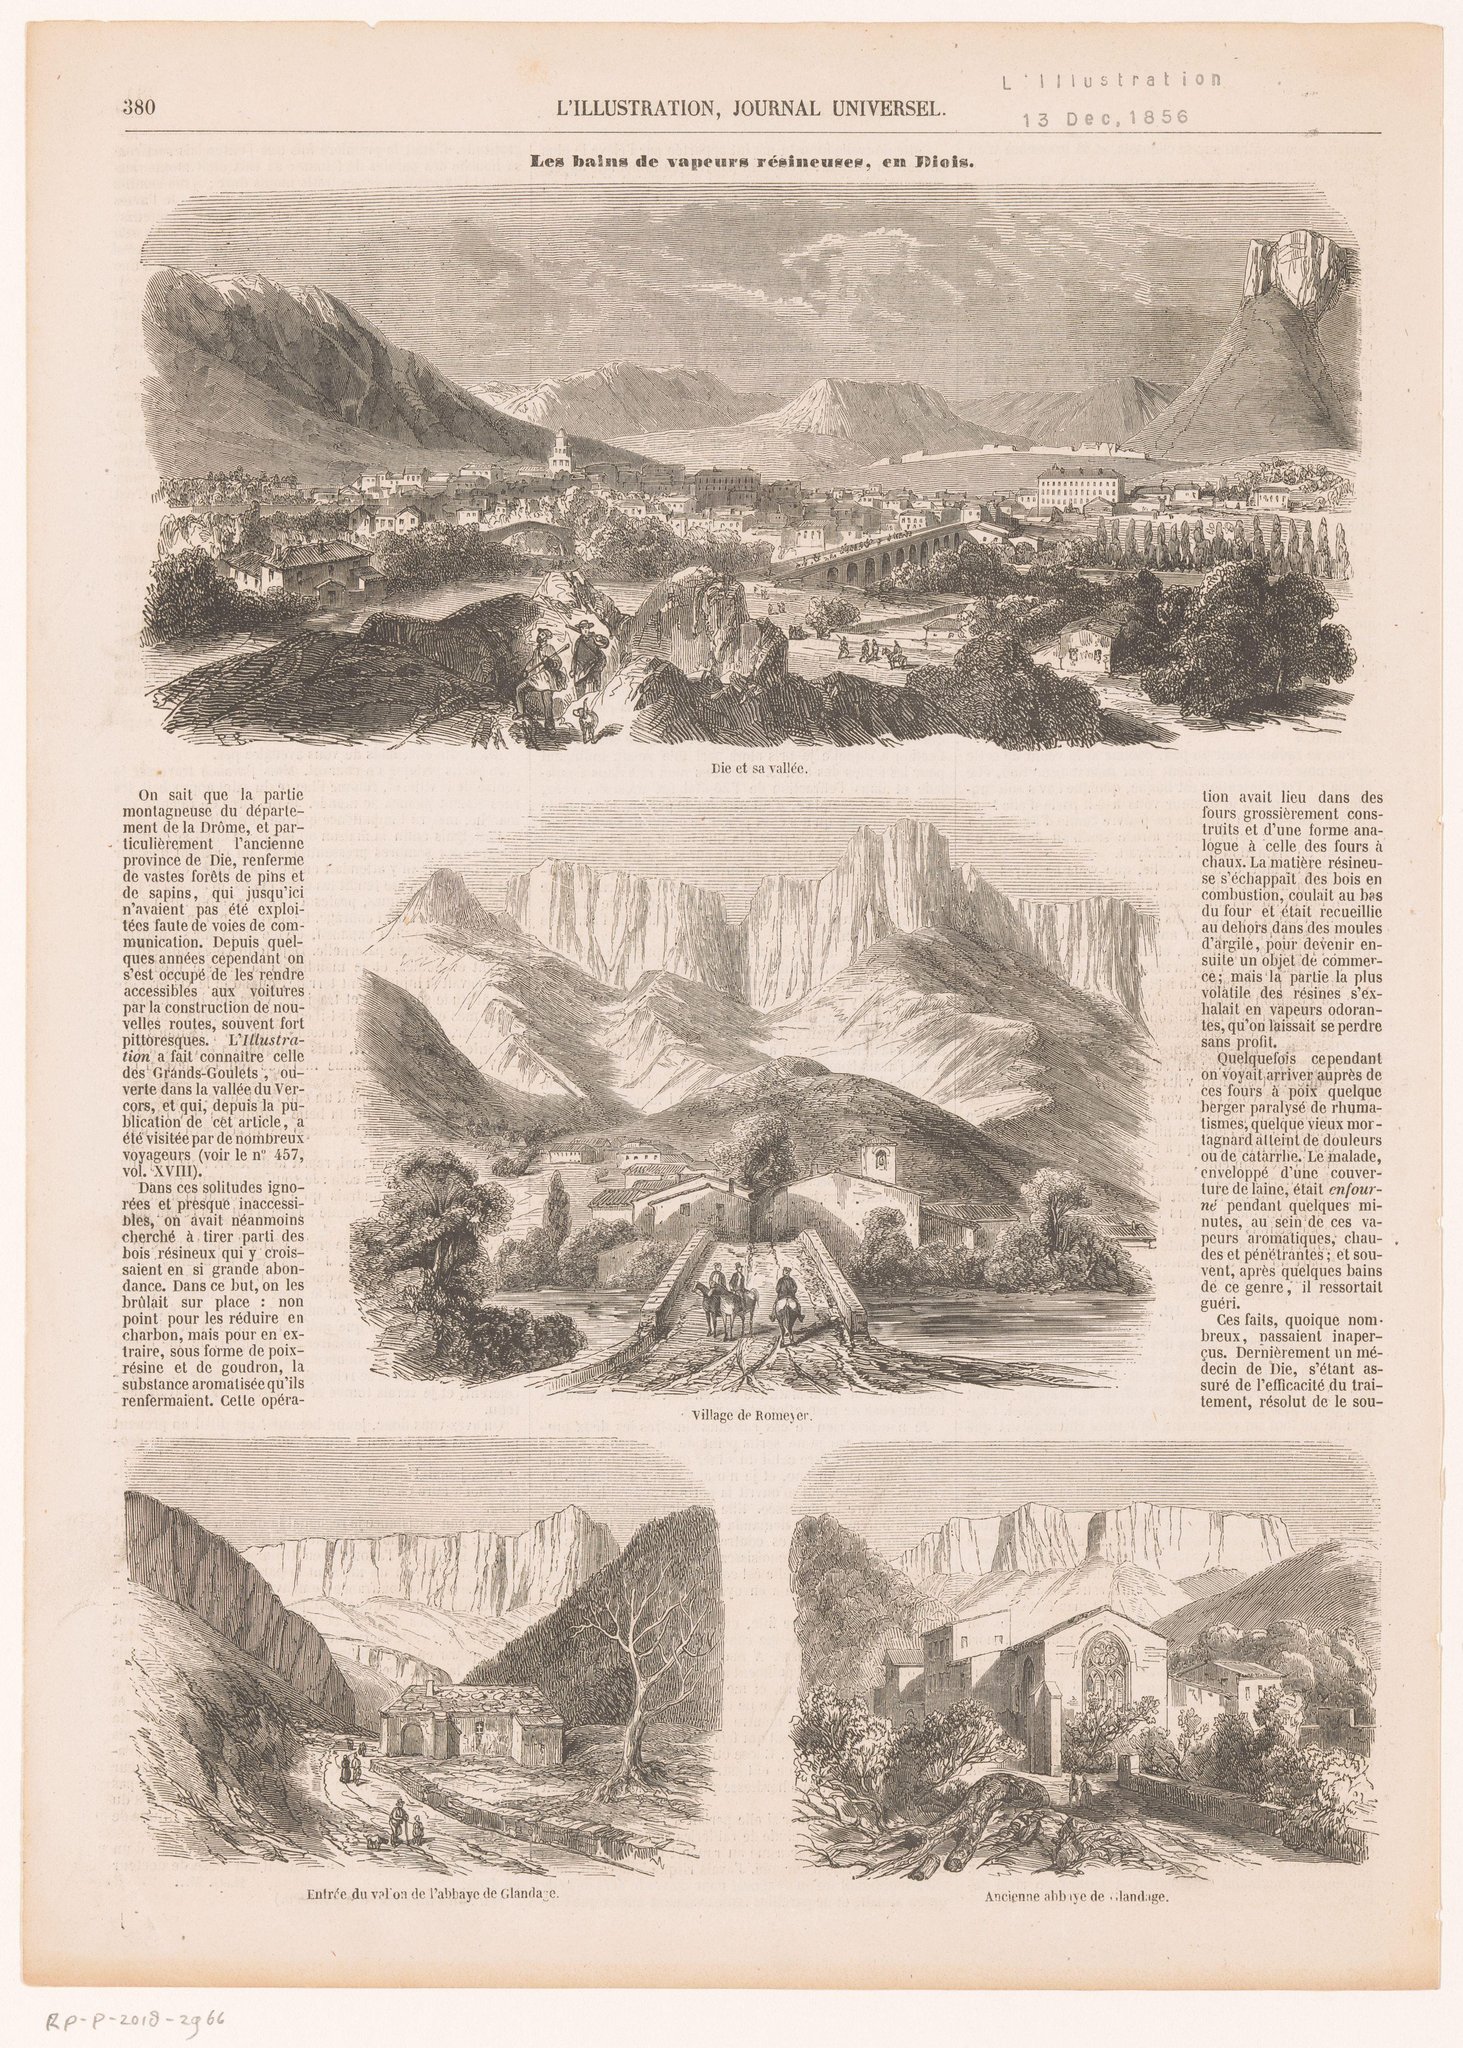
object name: page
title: Bains de vapeurs résineuses Diois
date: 1856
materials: paper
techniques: letterpress printing, engraving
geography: paris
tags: city-view, and landscape with man-made constructions, france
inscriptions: date: ‘L'Illustration 13 dec, 1856’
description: Prent uit: L'Illustration, Journal Universel 28 (1856), p. 380.